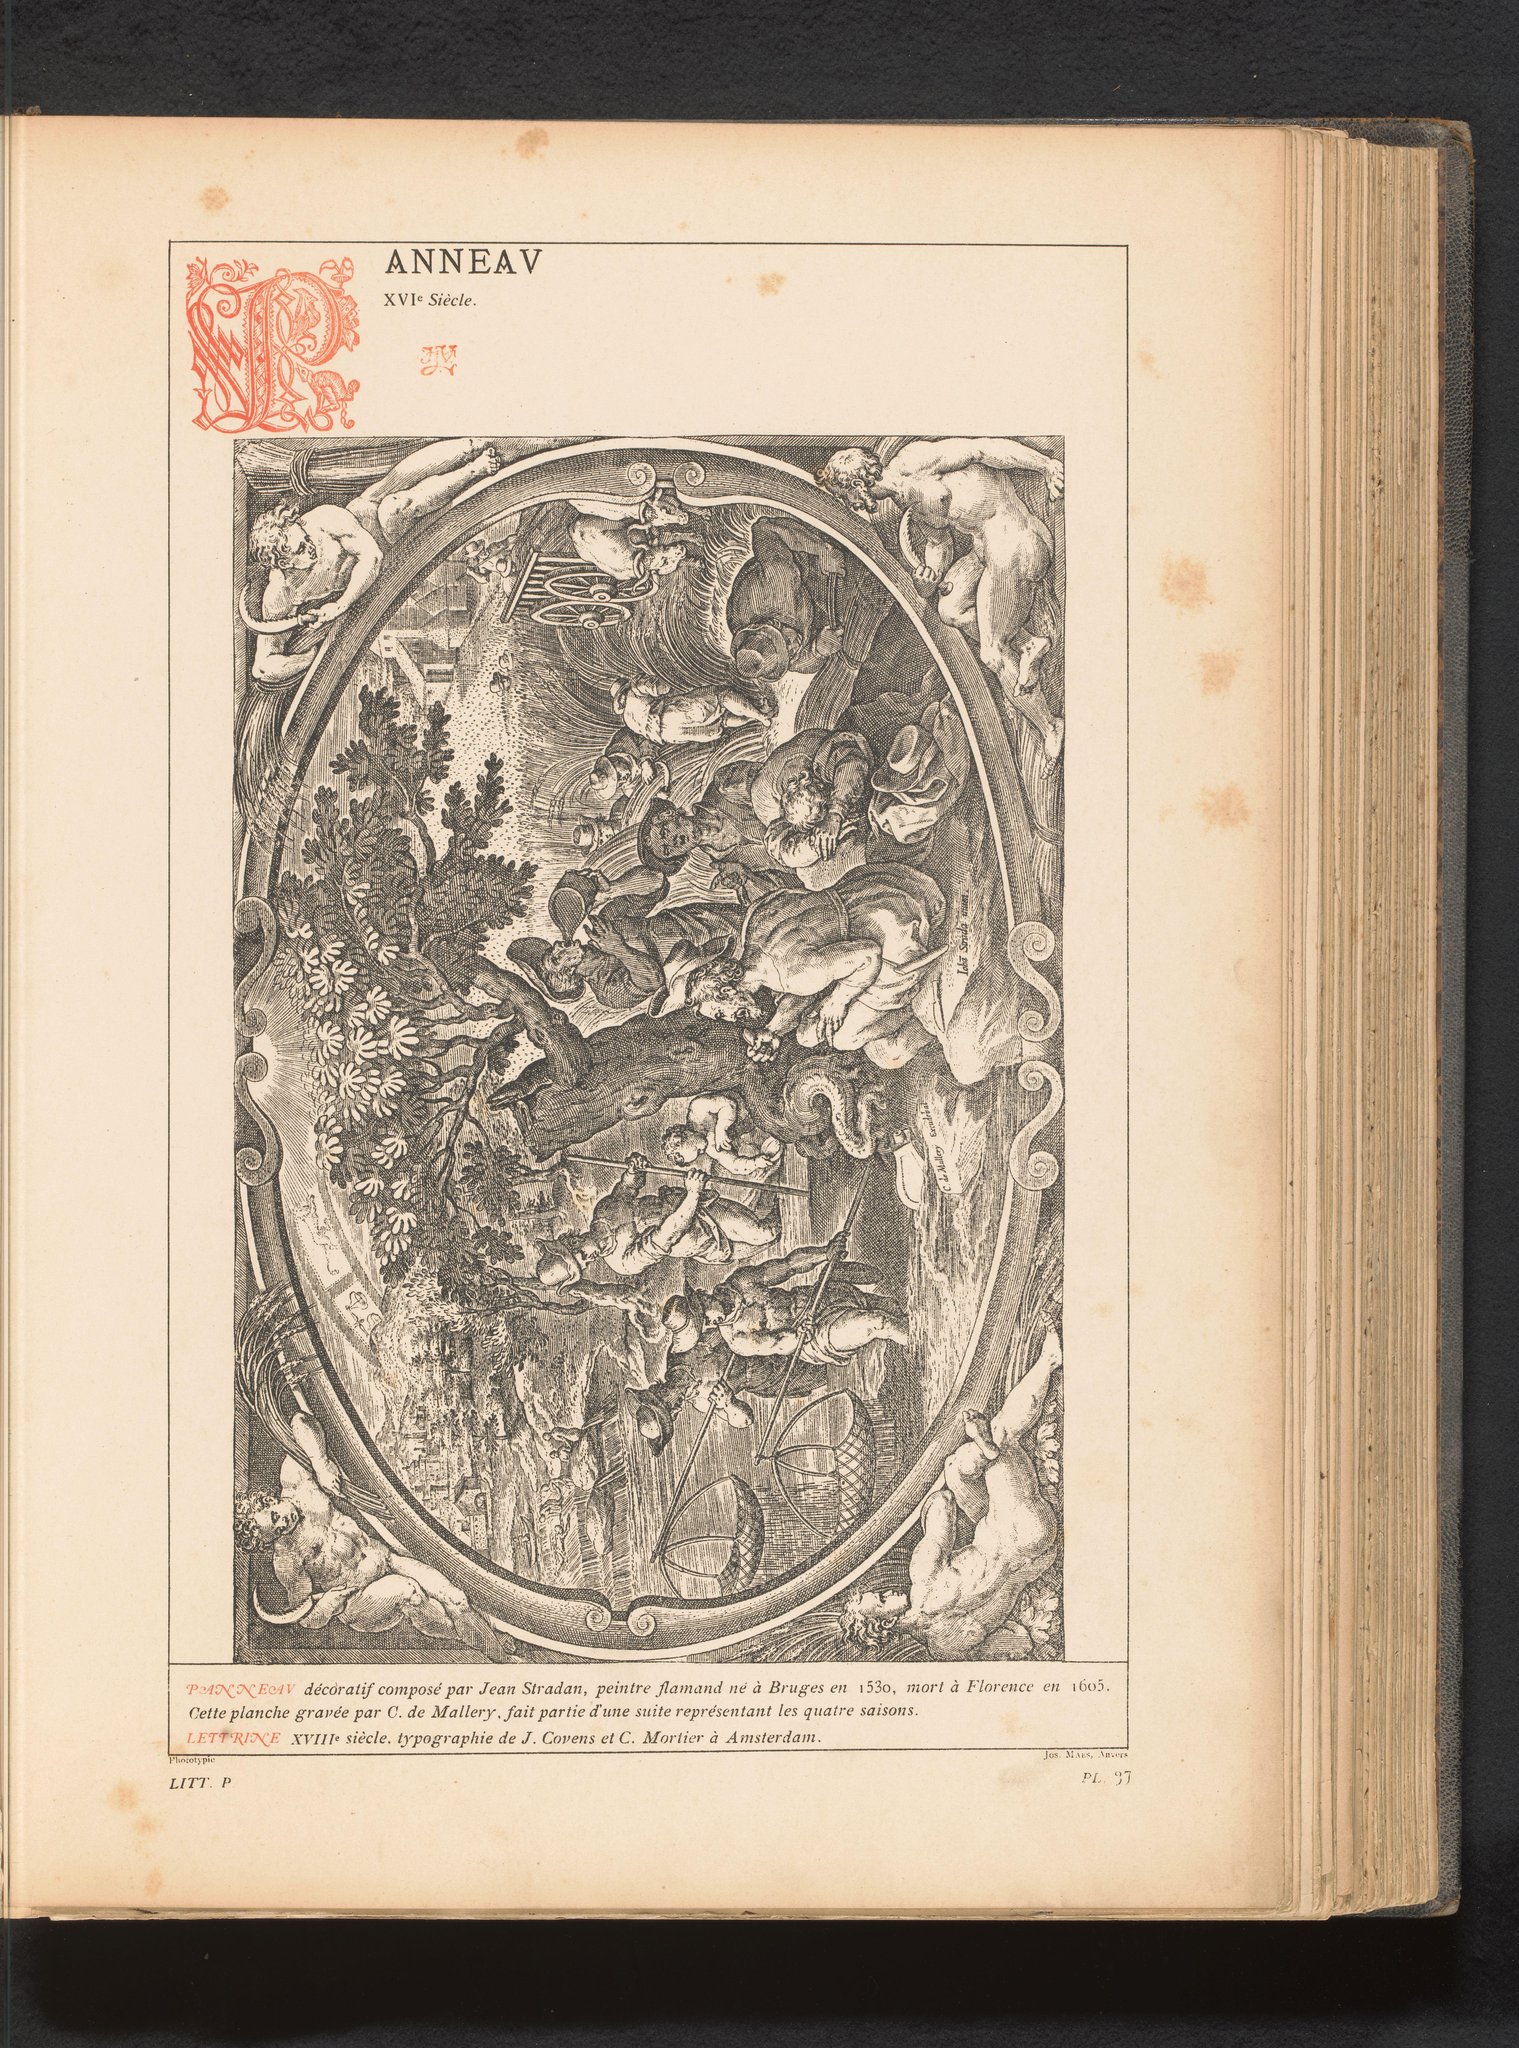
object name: reproduction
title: Reproductie van Zomer, een prent met vissers en landbouwers door Karel van Mallery naar ontwerp van Jan van der Straet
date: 1876-1881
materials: paper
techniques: photolithography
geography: antwerp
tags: fresh-water fishery, summer ~ human activities (the four seasons of the year), agriculture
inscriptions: monogram: ‘JJvY’, inscription: ‘PANNEAU décòratif composé (...)’, inscription: ‘LITT. P. - PL. 37.’